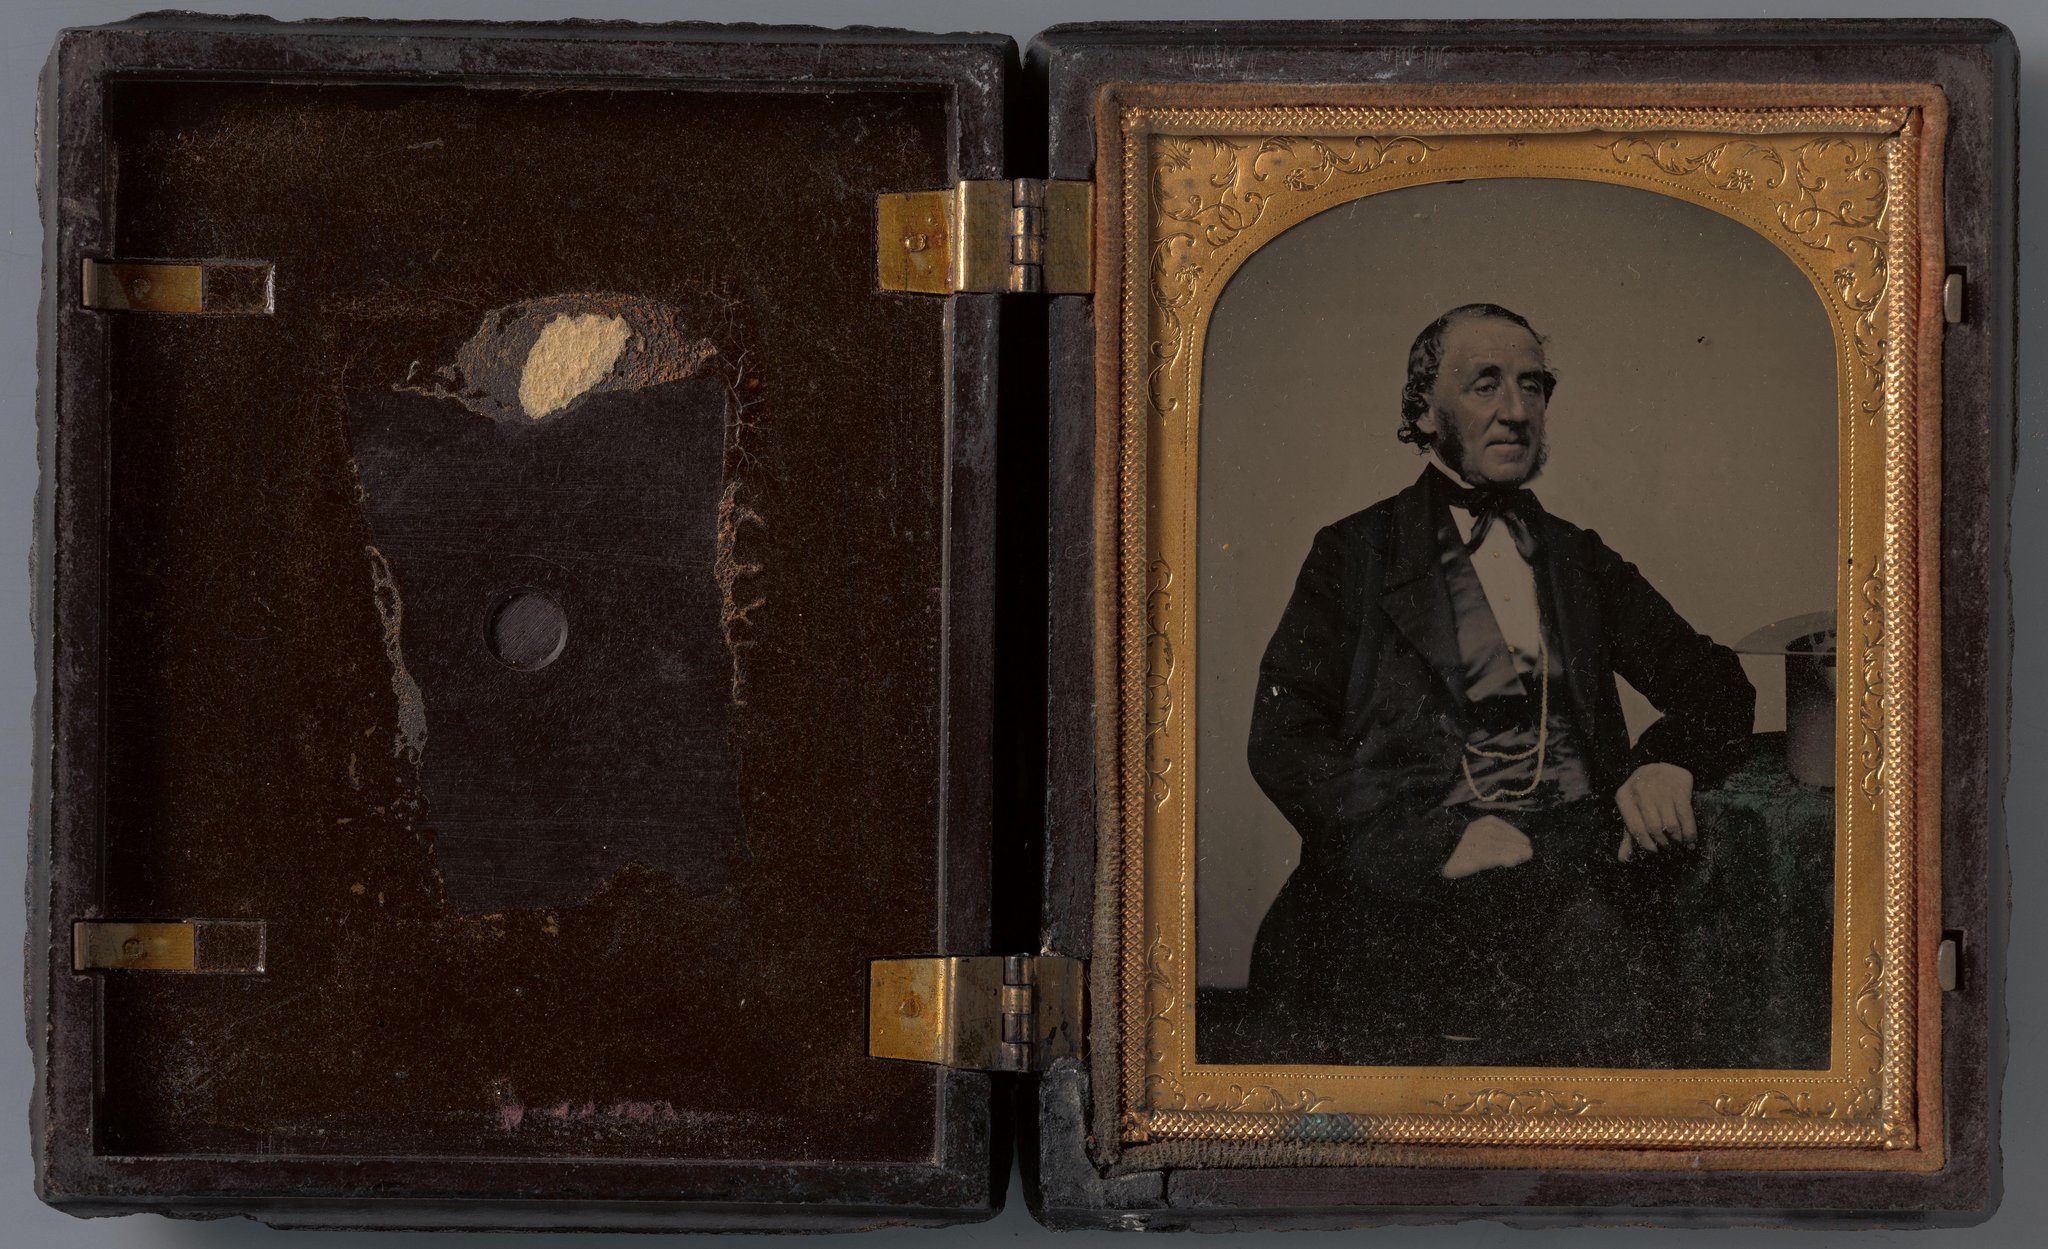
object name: photograph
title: Portret van een onbekende man met bakkebaarden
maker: Anonymous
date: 1855-1870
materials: glass, metal, plastic, textile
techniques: ambrotype, hand coloring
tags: sideburns, historical persons